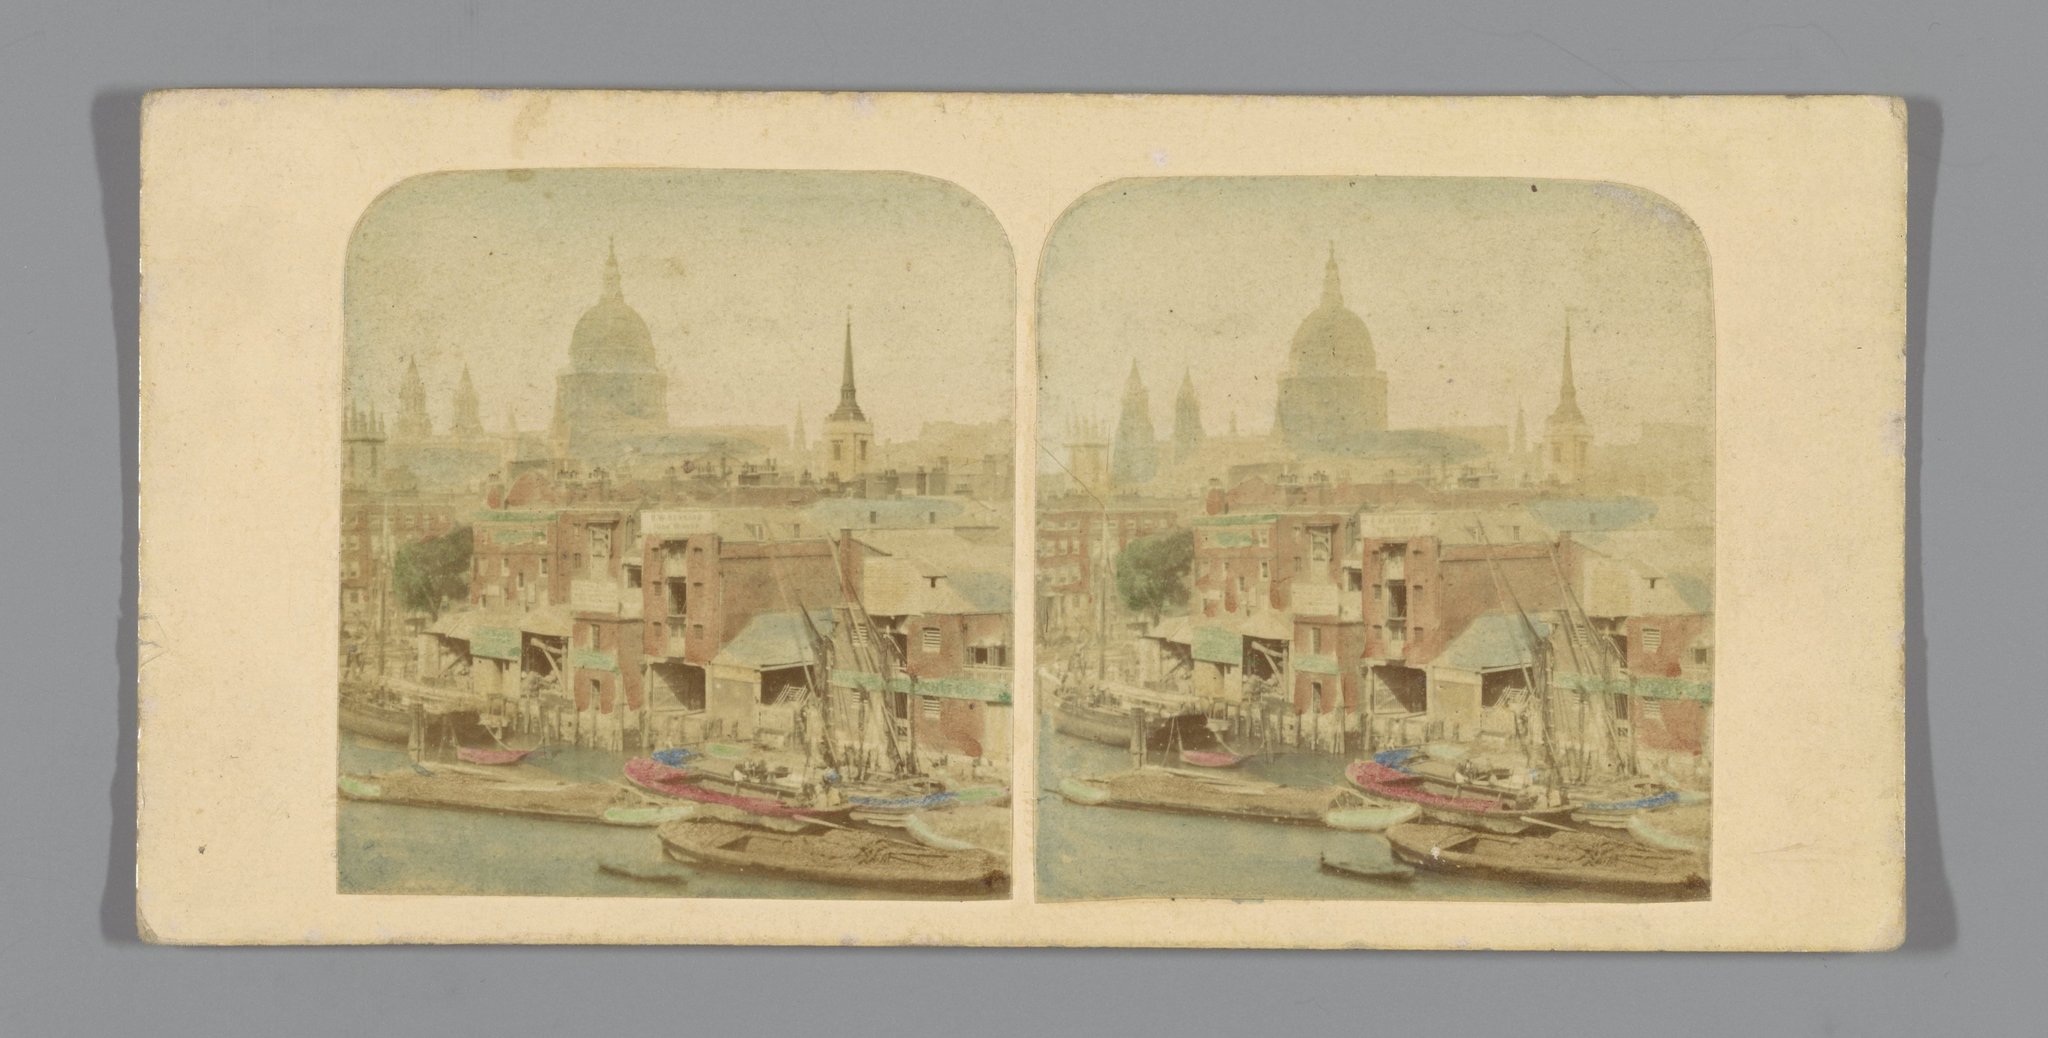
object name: stereograph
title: St. Paul's Cathedral, from Southwark Bridge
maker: Anonymous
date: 1850-1880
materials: cardboard, photographic support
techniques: albumen print, hand coloring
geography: london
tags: church (exterior), dome ~ architecture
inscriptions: number: ‘19.’, inscription: ‘vd. B. 1863.’